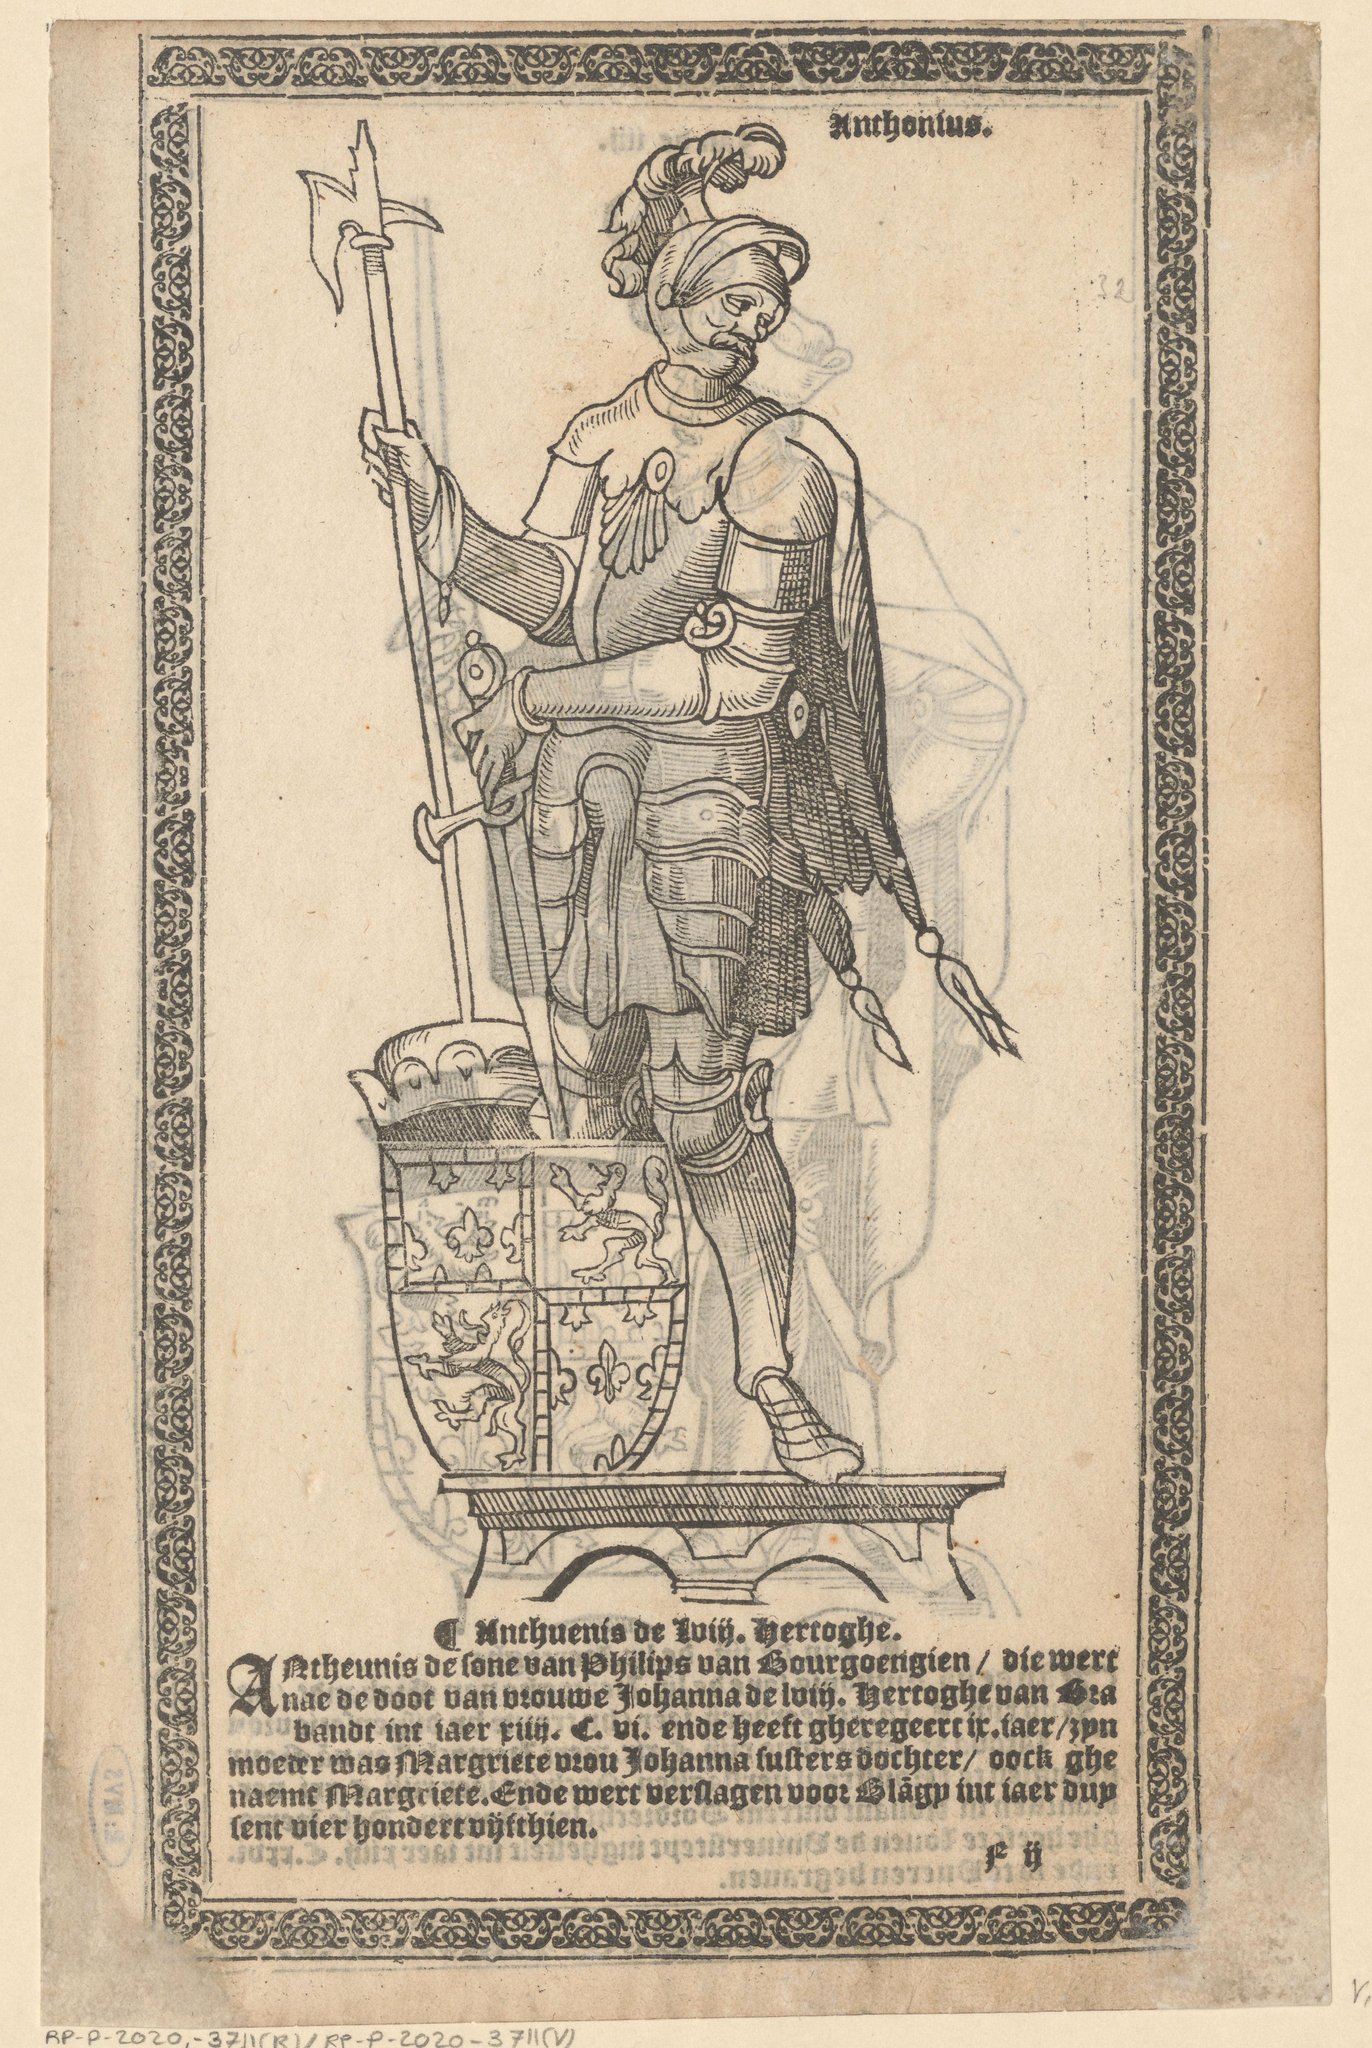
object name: book illustration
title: Portret van Anton van Bourgondië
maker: jan molijns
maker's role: print maker, publisher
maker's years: 1498-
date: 1565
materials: paper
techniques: letterpress printing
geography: antwerp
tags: helmet, helved weapons, polearms (for striking, hacking, thrusting): pike, armour, historical persons, armorial bearing, heraldry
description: Prent uit: Dit is die afcoemste ende genalogie der hertoghen ende hertoginnen van Brabandt, (...). Antwerpen: Jan Molijns, 1565.